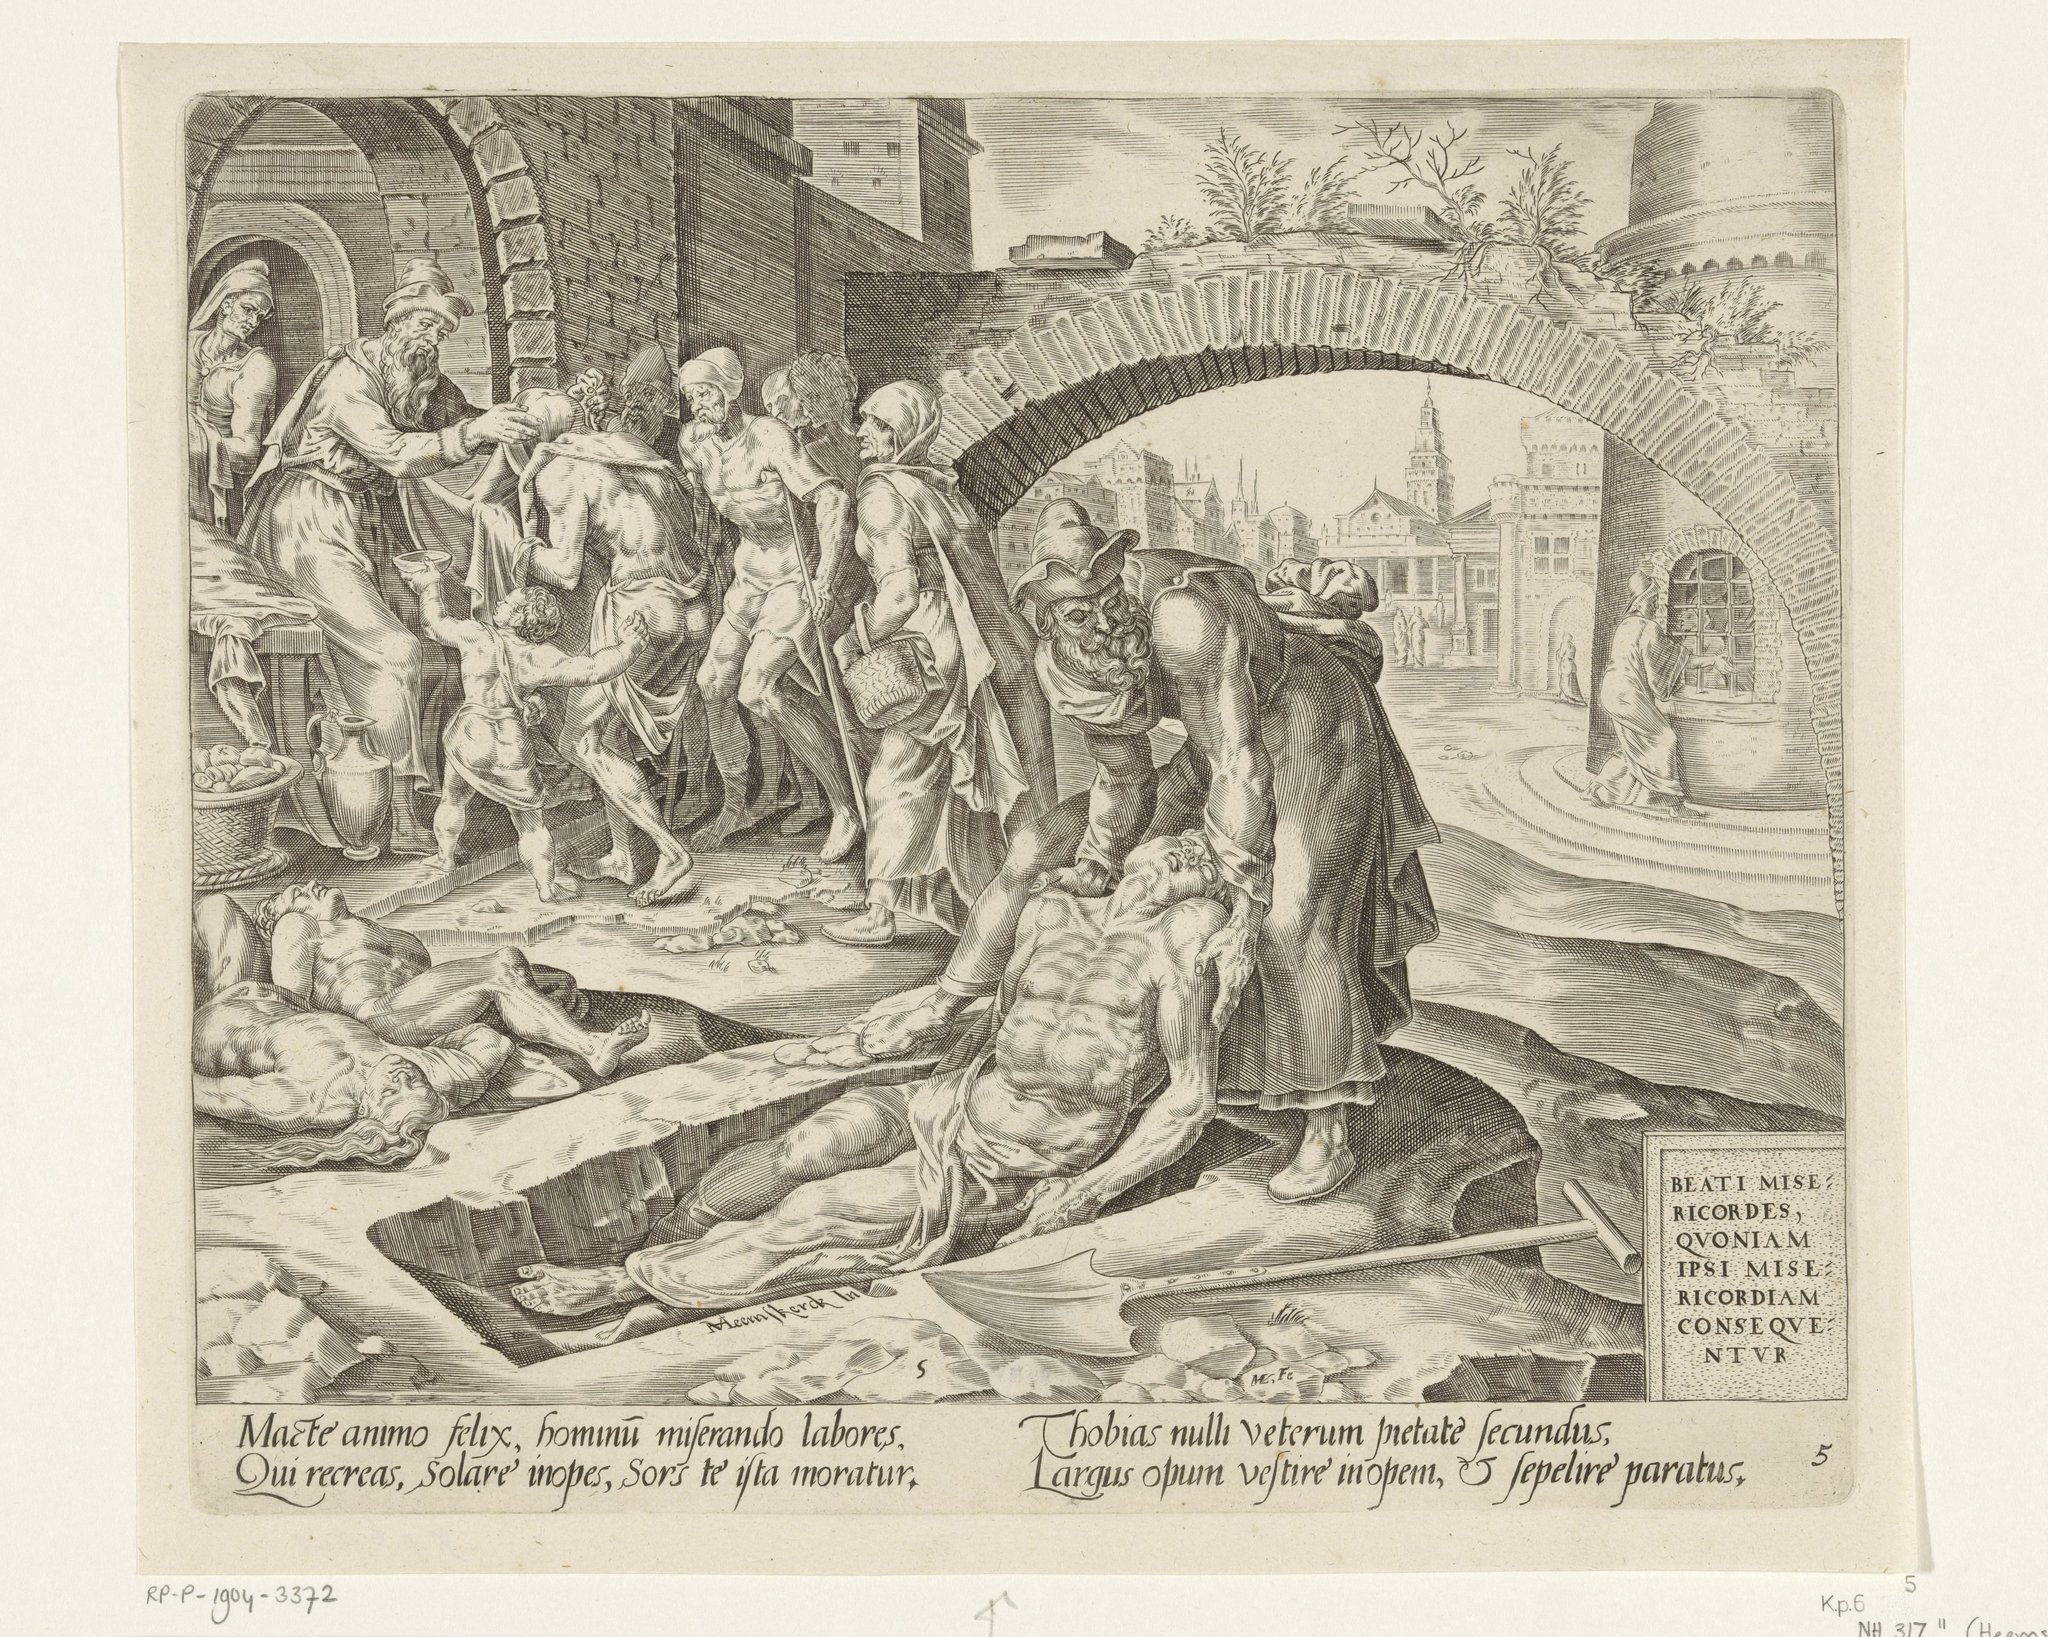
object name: print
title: Tobit toont barmhartigheid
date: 1564-1568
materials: paper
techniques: engraving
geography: amsterdam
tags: blessed are the merciful, the piety of the old tobit (tobit 1:10-22)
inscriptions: collector's mark: Lugt 2228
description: Tobit toont barmhartigheid door de doden naar behoren te begraven. Links geven Tobit en zijn vrouw Anna eten, drinken en kleding aan de armen. Rechts bezoekt Tobit een gevangene. Prent maakt deel uit van een serie over de acht zaligsprekingen van Christus en illustreert de zaligspreking: Zalig de barmhartigen. In de rechter benedenhoek deze tekst uit Mat. 5:7 in het Latijn. Onderaan in de marge een vers in het Latijn over de zaligspreking en de voorstelling.